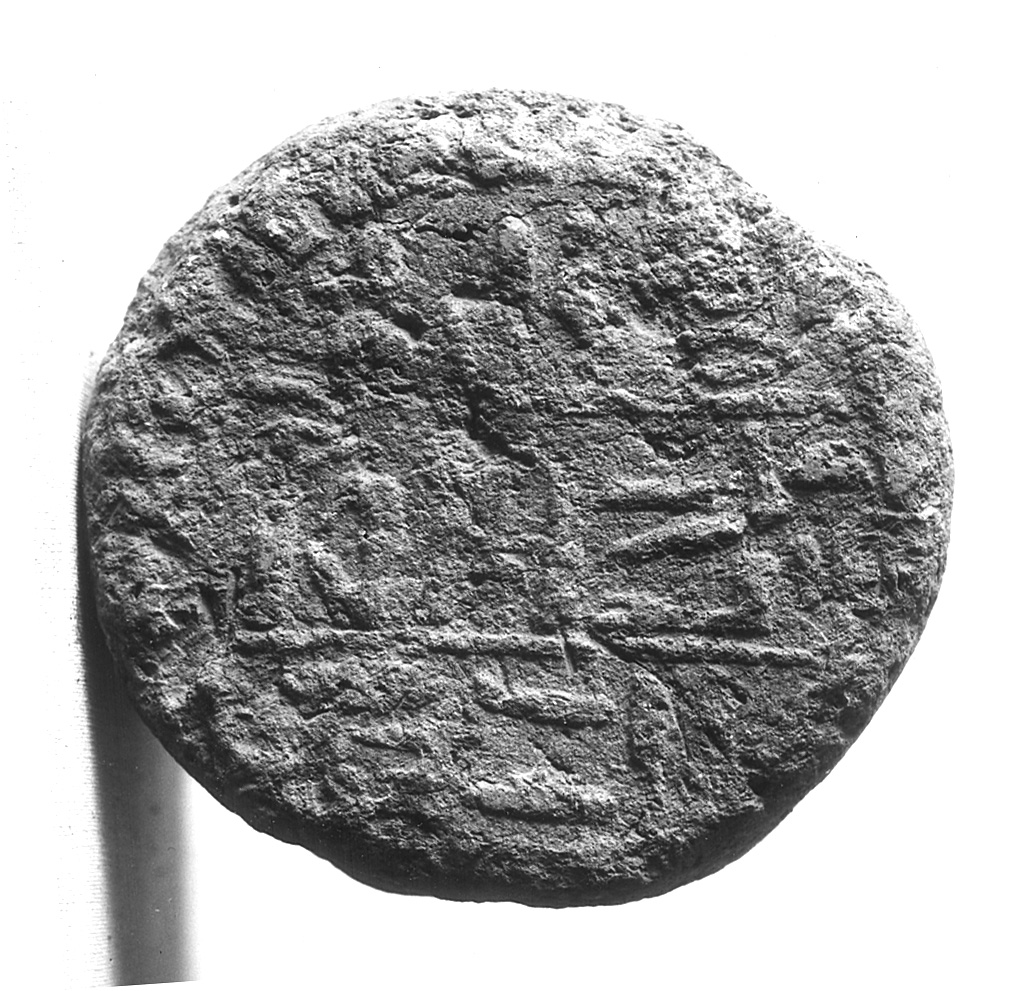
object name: cone, circular impression, maaty, scribe, huy, house mistress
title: Funerary Cone of Maaty and His Wife Huy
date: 1550-1352 BCE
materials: pottery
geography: egypt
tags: hieroglyphs